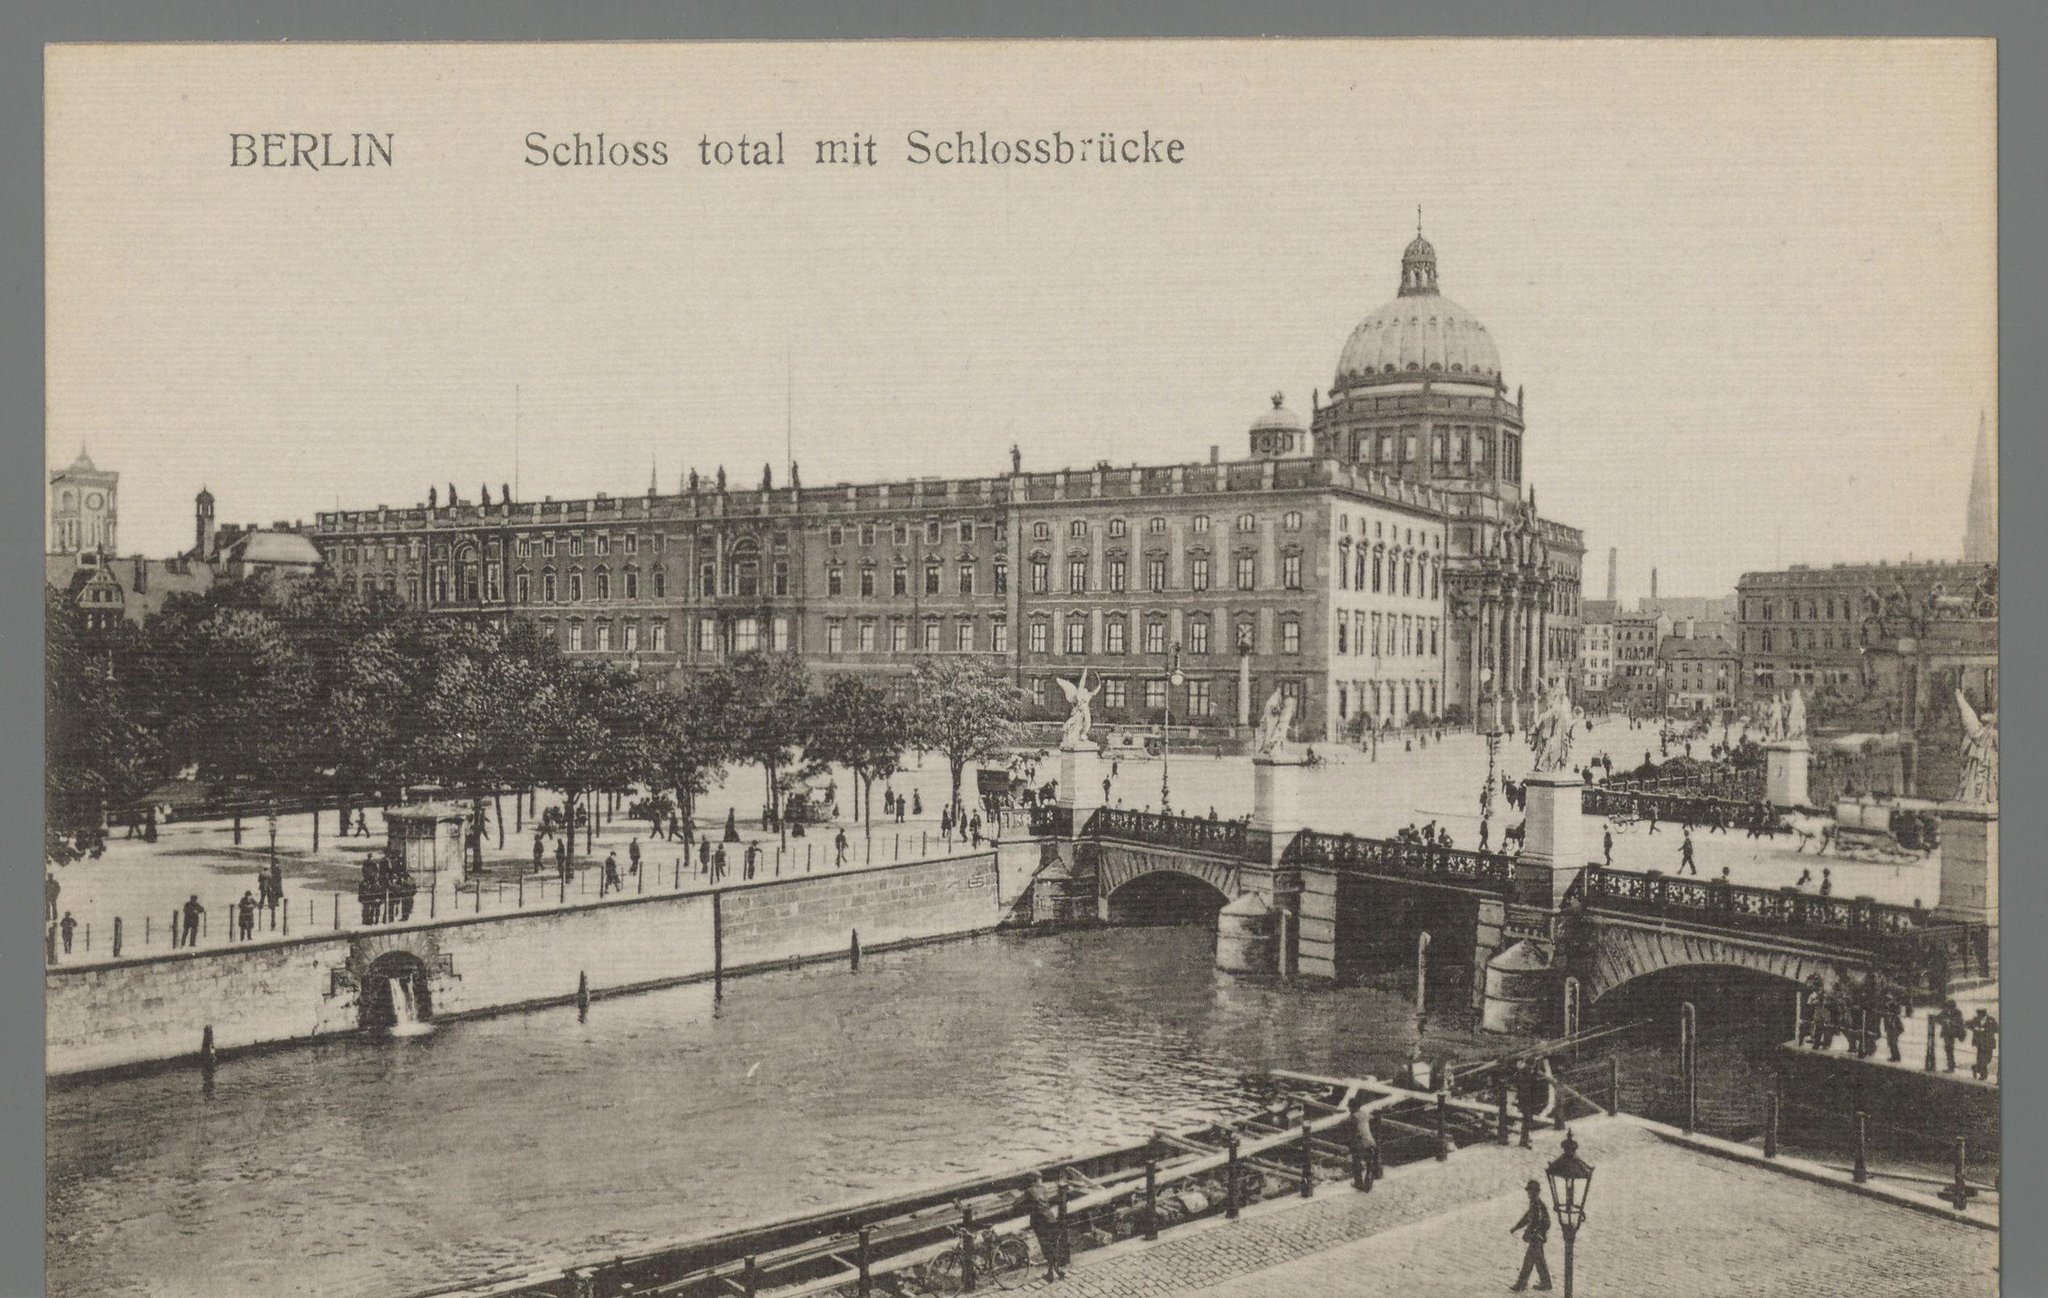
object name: ansichtkaart, prentbriefkaart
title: Berlin. Schloss total mit Schlossbrücke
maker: Anonymous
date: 1905-1930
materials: cardboard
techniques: photograph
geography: berlin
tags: castle, bridge in city across river, canal, etc.